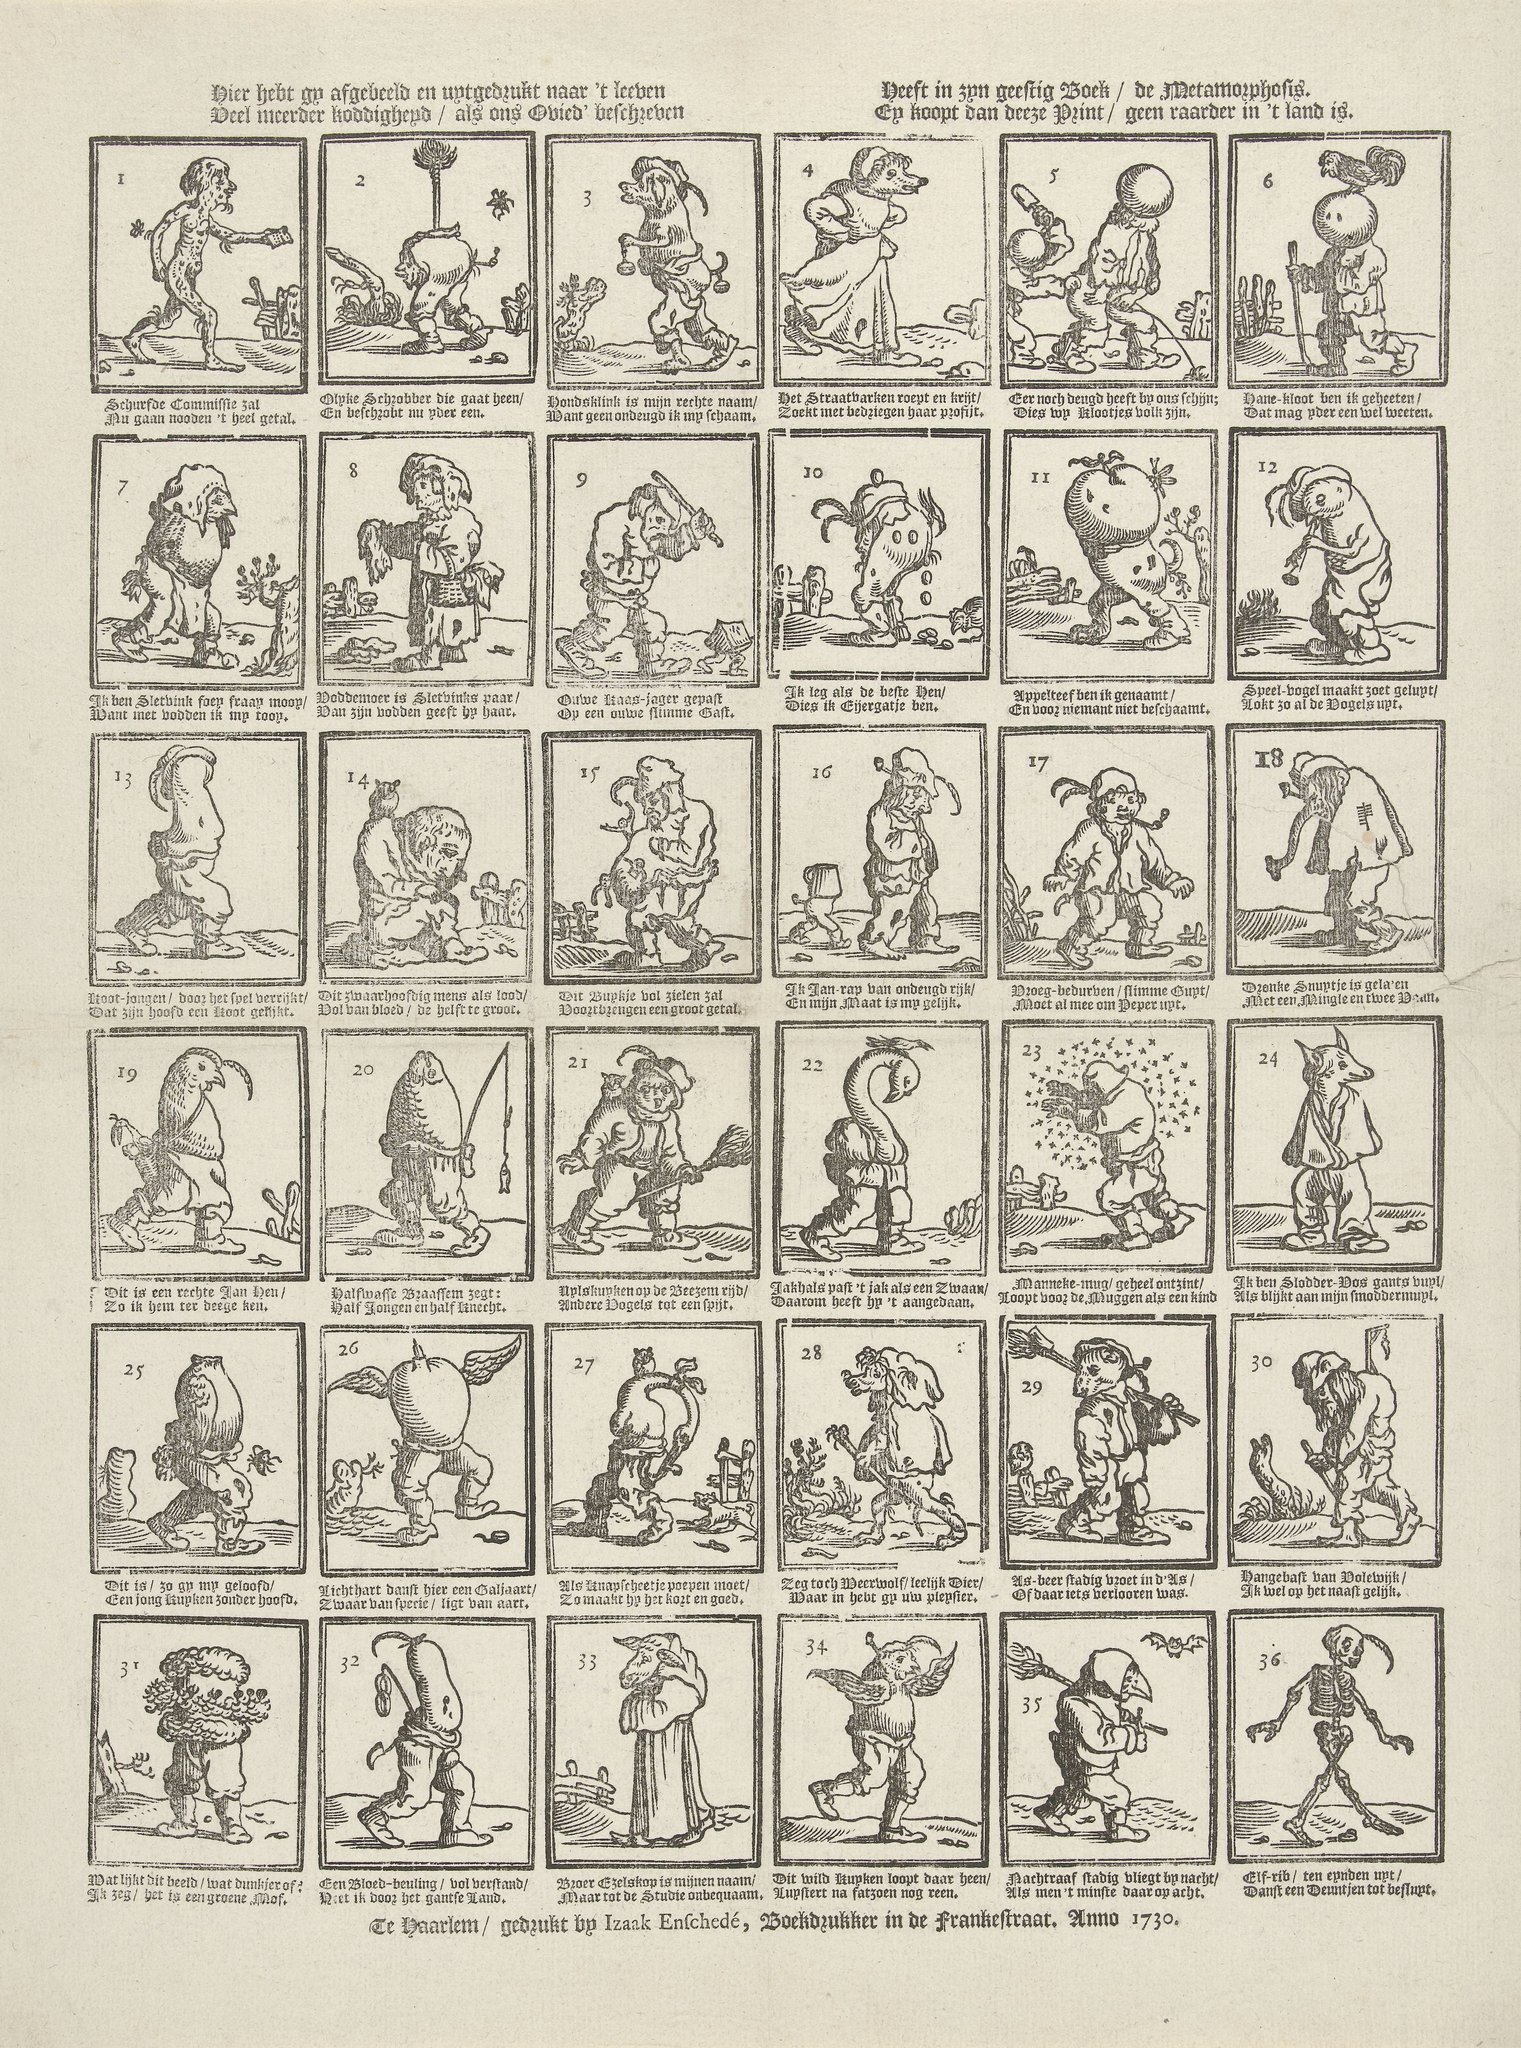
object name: print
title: Hier hebt gy afgebeeld en uytgedrukt naar 't leeven / Veel meerder koddigheyd / als ons Ovied' beschreven (...).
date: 1730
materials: paper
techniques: letterpress printing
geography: netherlands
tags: caricatures (human types)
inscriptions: collector's mark: Lugt 2228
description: Blad met 36 satirische voorstellingen van koddige figuren. Elk afzonderlijk plaatje is genummerd en heeft een tweeregelig onderschrift met een rijm op zijn of haar schimp- of scheldnaam.